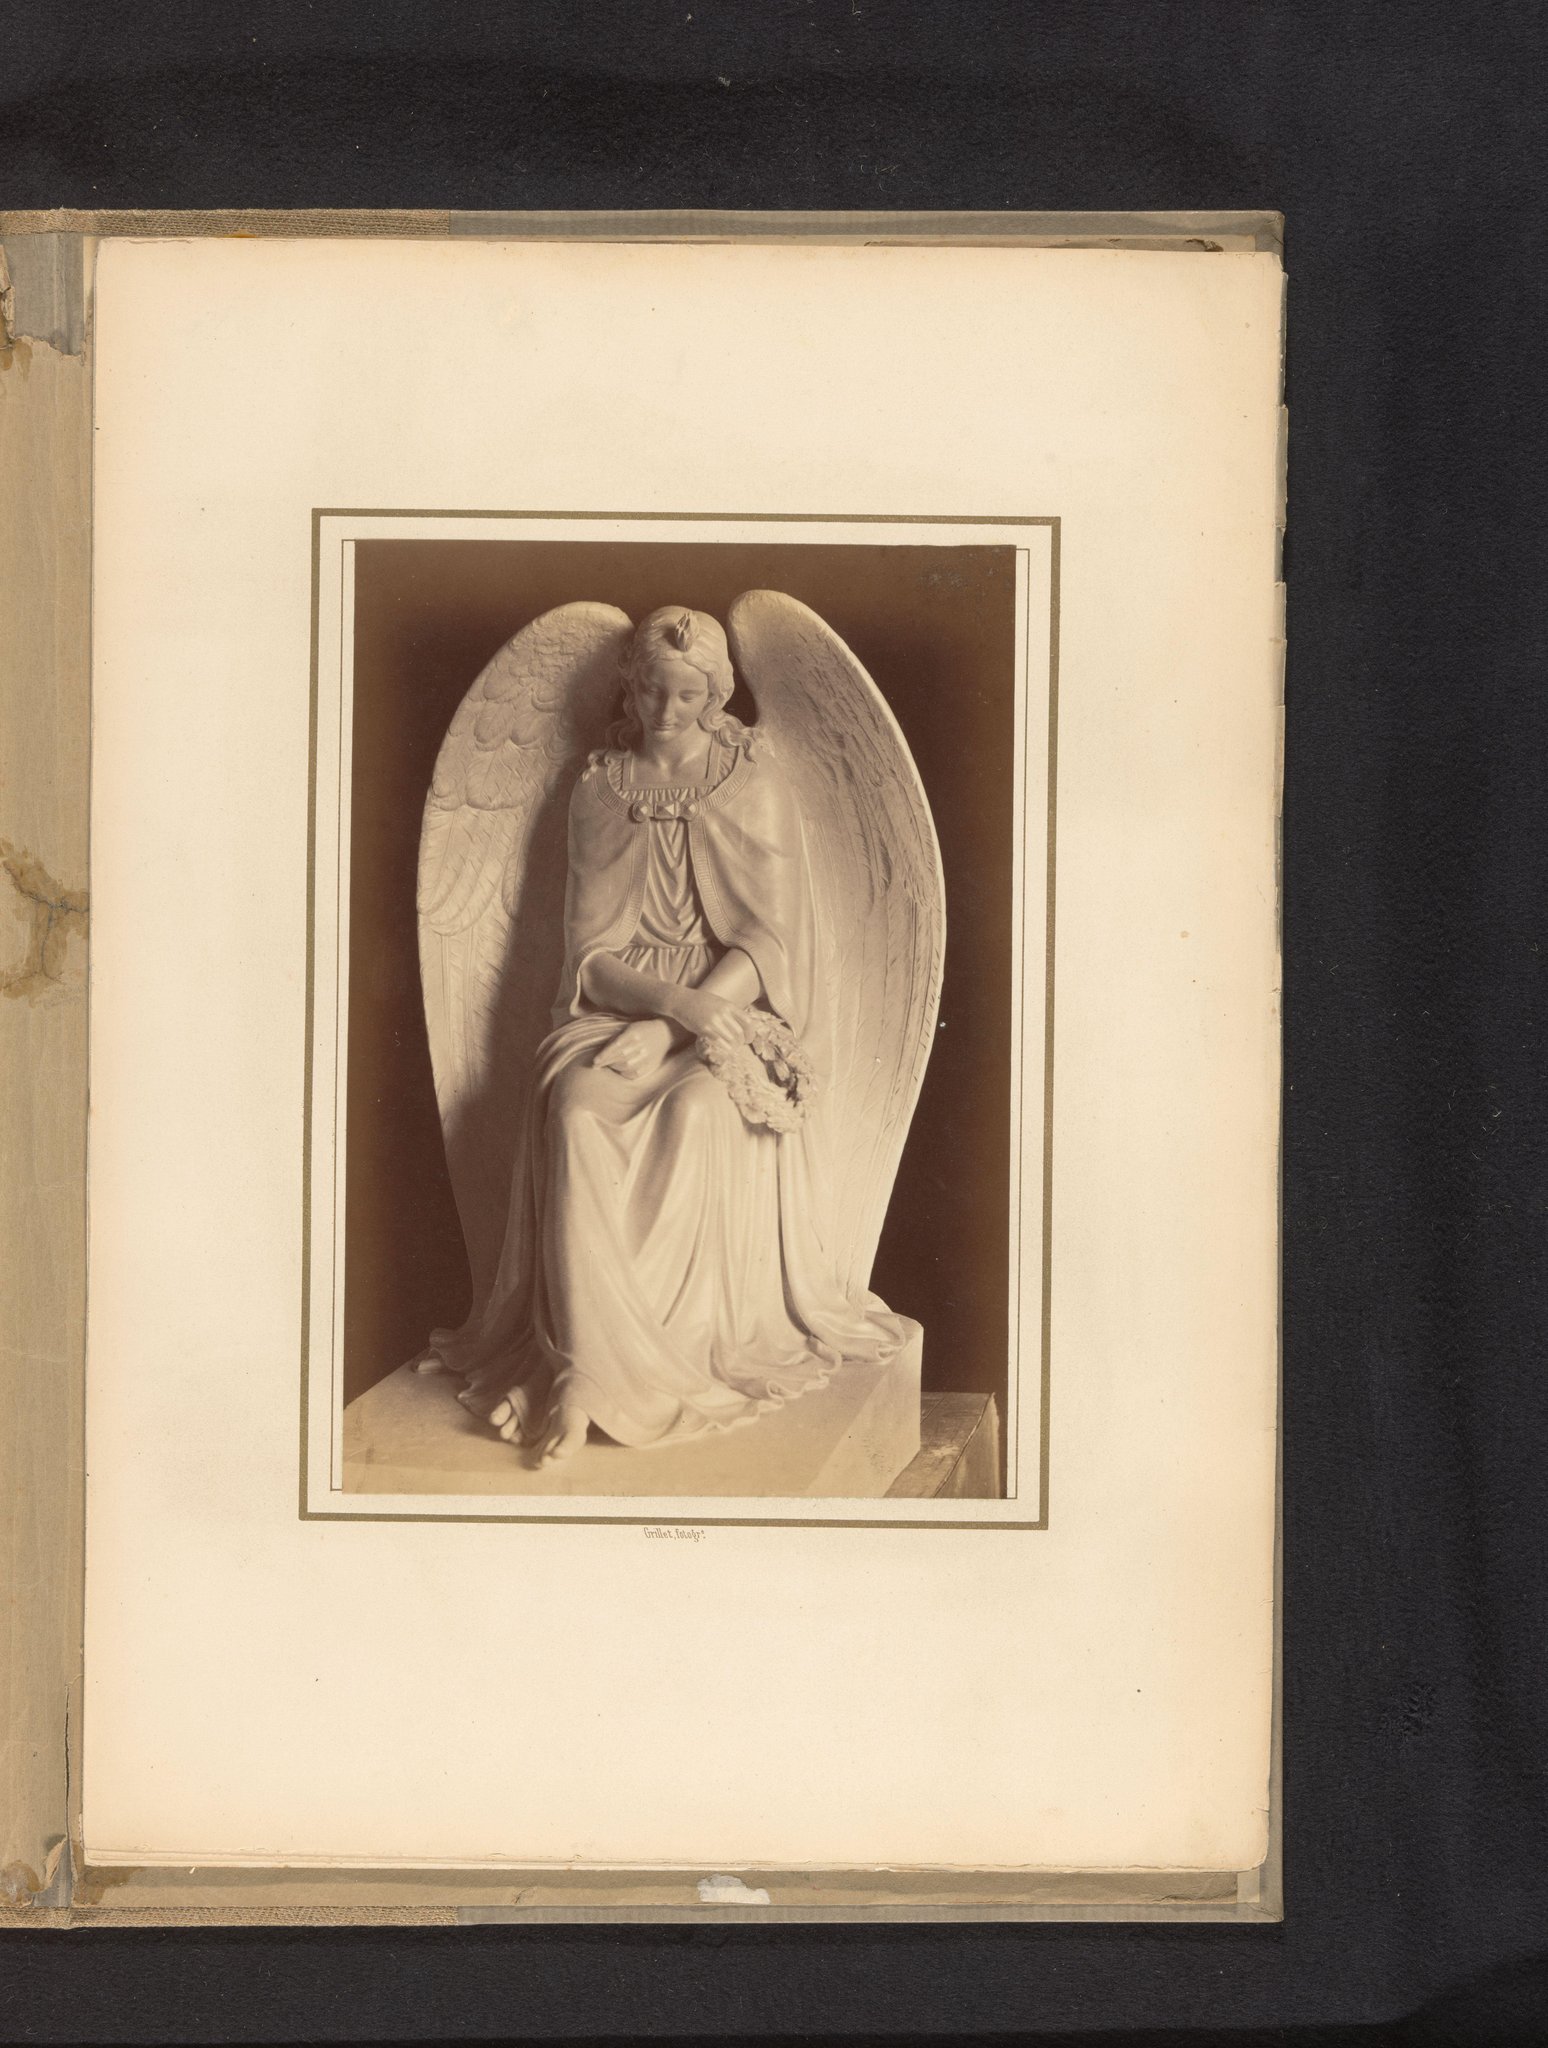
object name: photograph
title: Sculptuur van een vrouwelijke engel door Leopold Borbone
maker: grillet jeune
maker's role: fotograaf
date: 1854-1859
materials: photographic support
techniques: albumen print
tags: female angels, piece of sculpture, reproduction of a piece of sculpture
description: Deze foto maakt deel uit van een omslag met 18 foto's op 18 bladen en 14 tekstbladen.